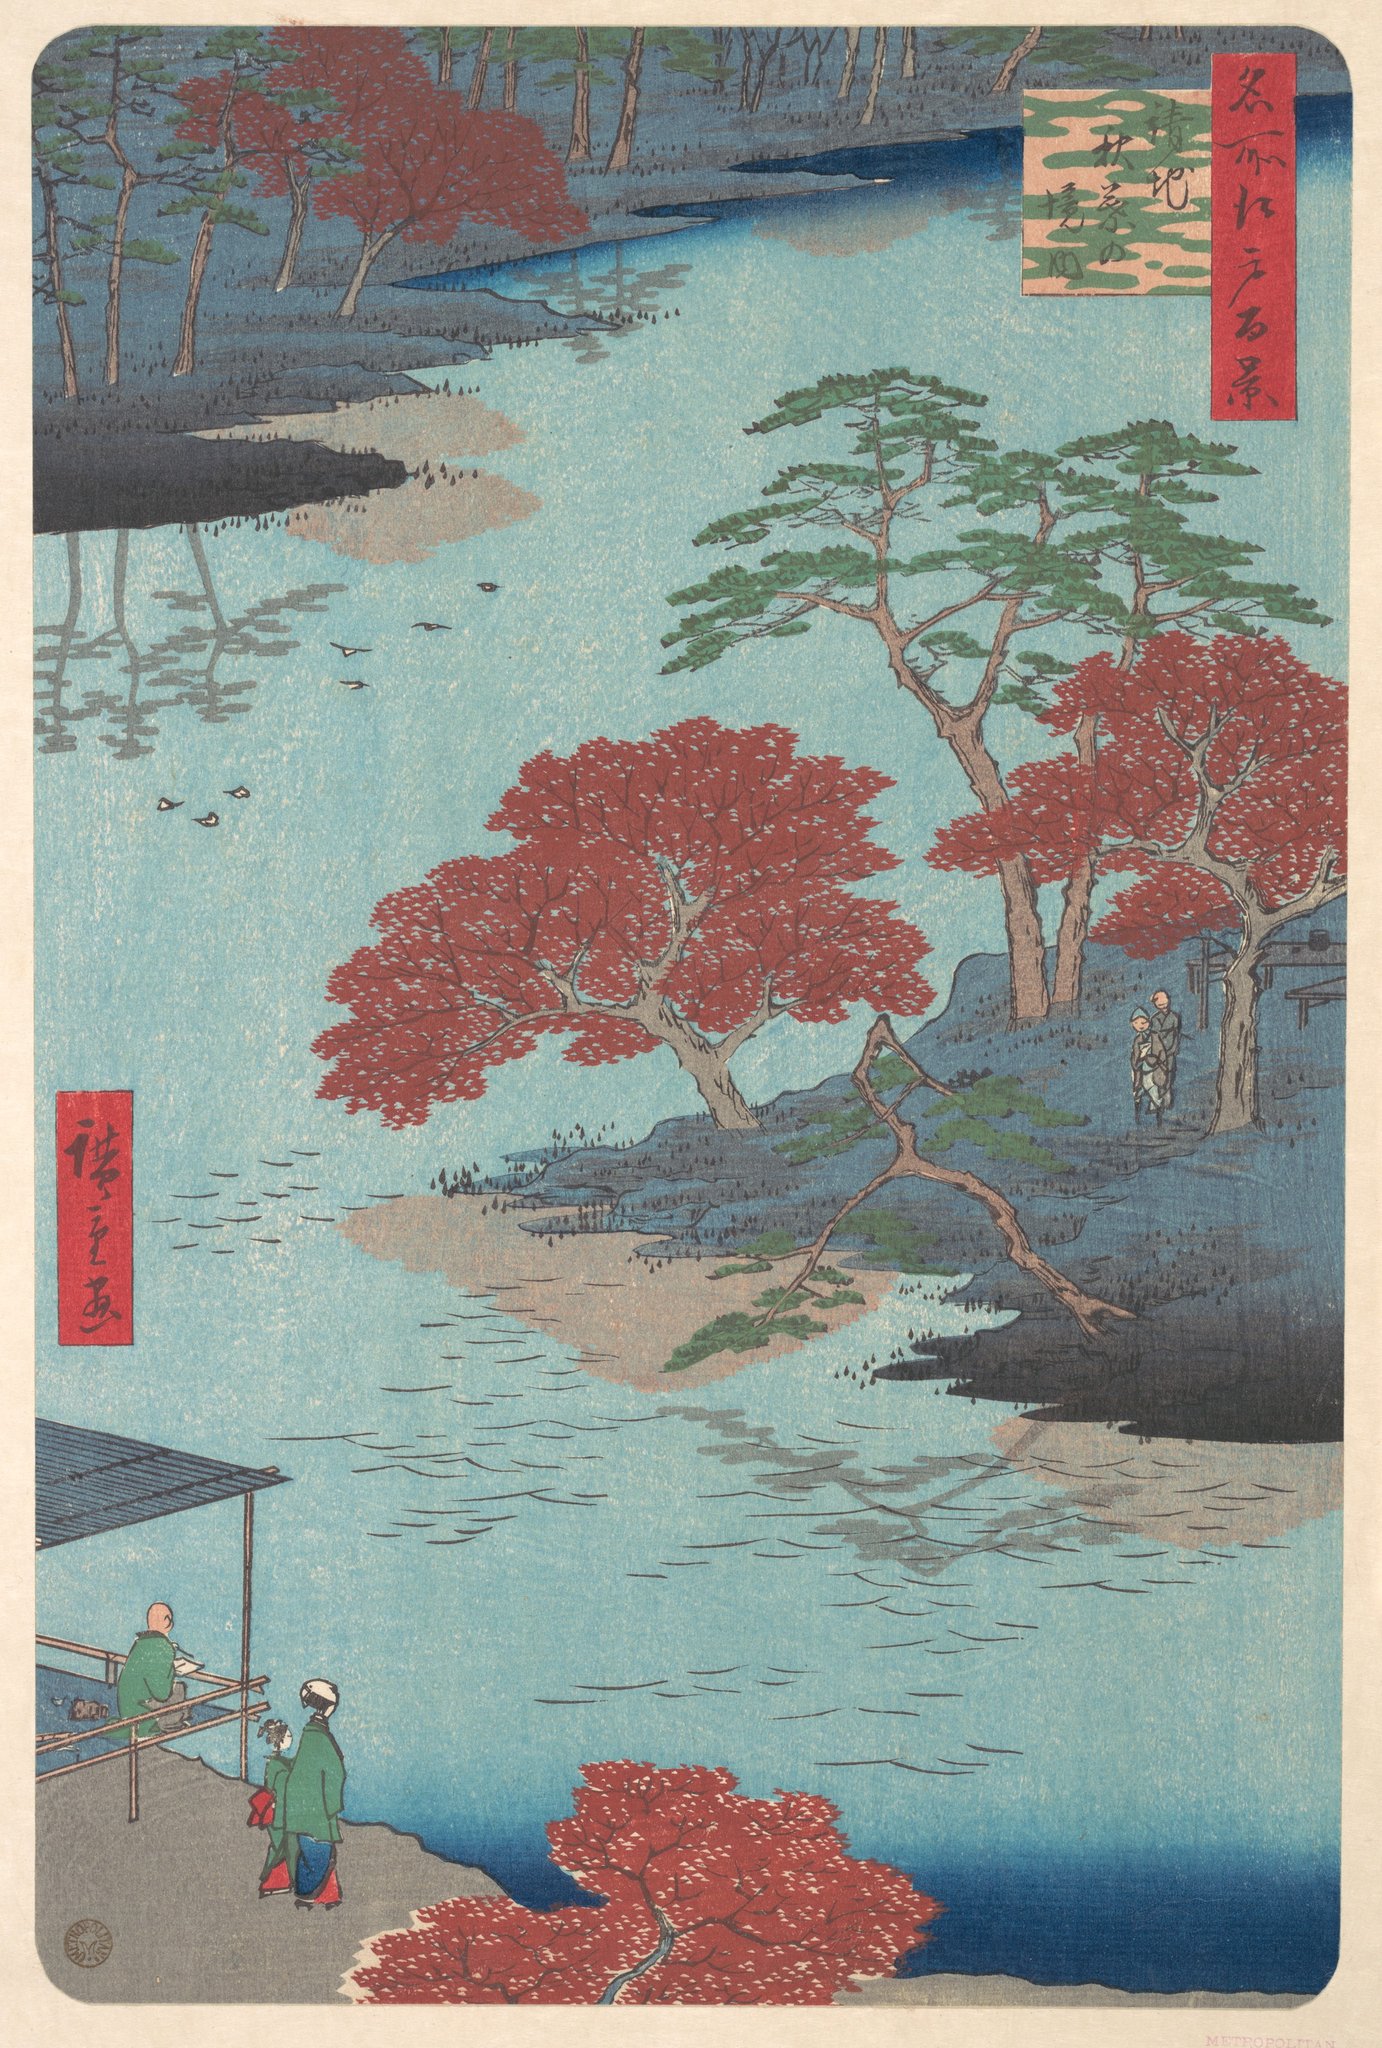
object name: print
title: Inside the Akiba Shrine at Ukeji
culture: japanese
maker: utagawa hiroshige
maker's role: artist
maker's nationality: japanese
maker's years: 1797-1858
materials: ink, paper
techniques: woodblock print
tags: human figures,trees